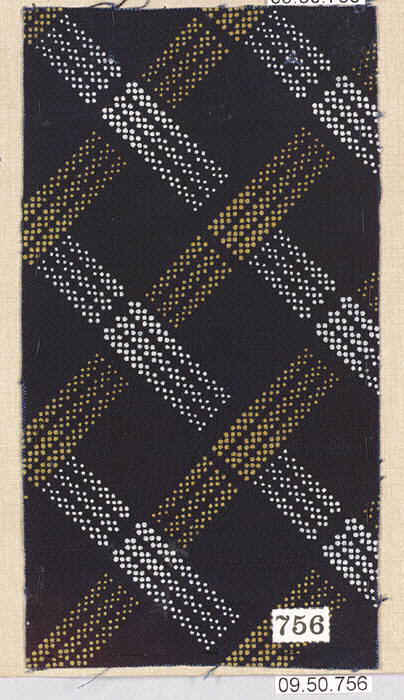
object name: piece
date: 1801-1900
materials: cotton